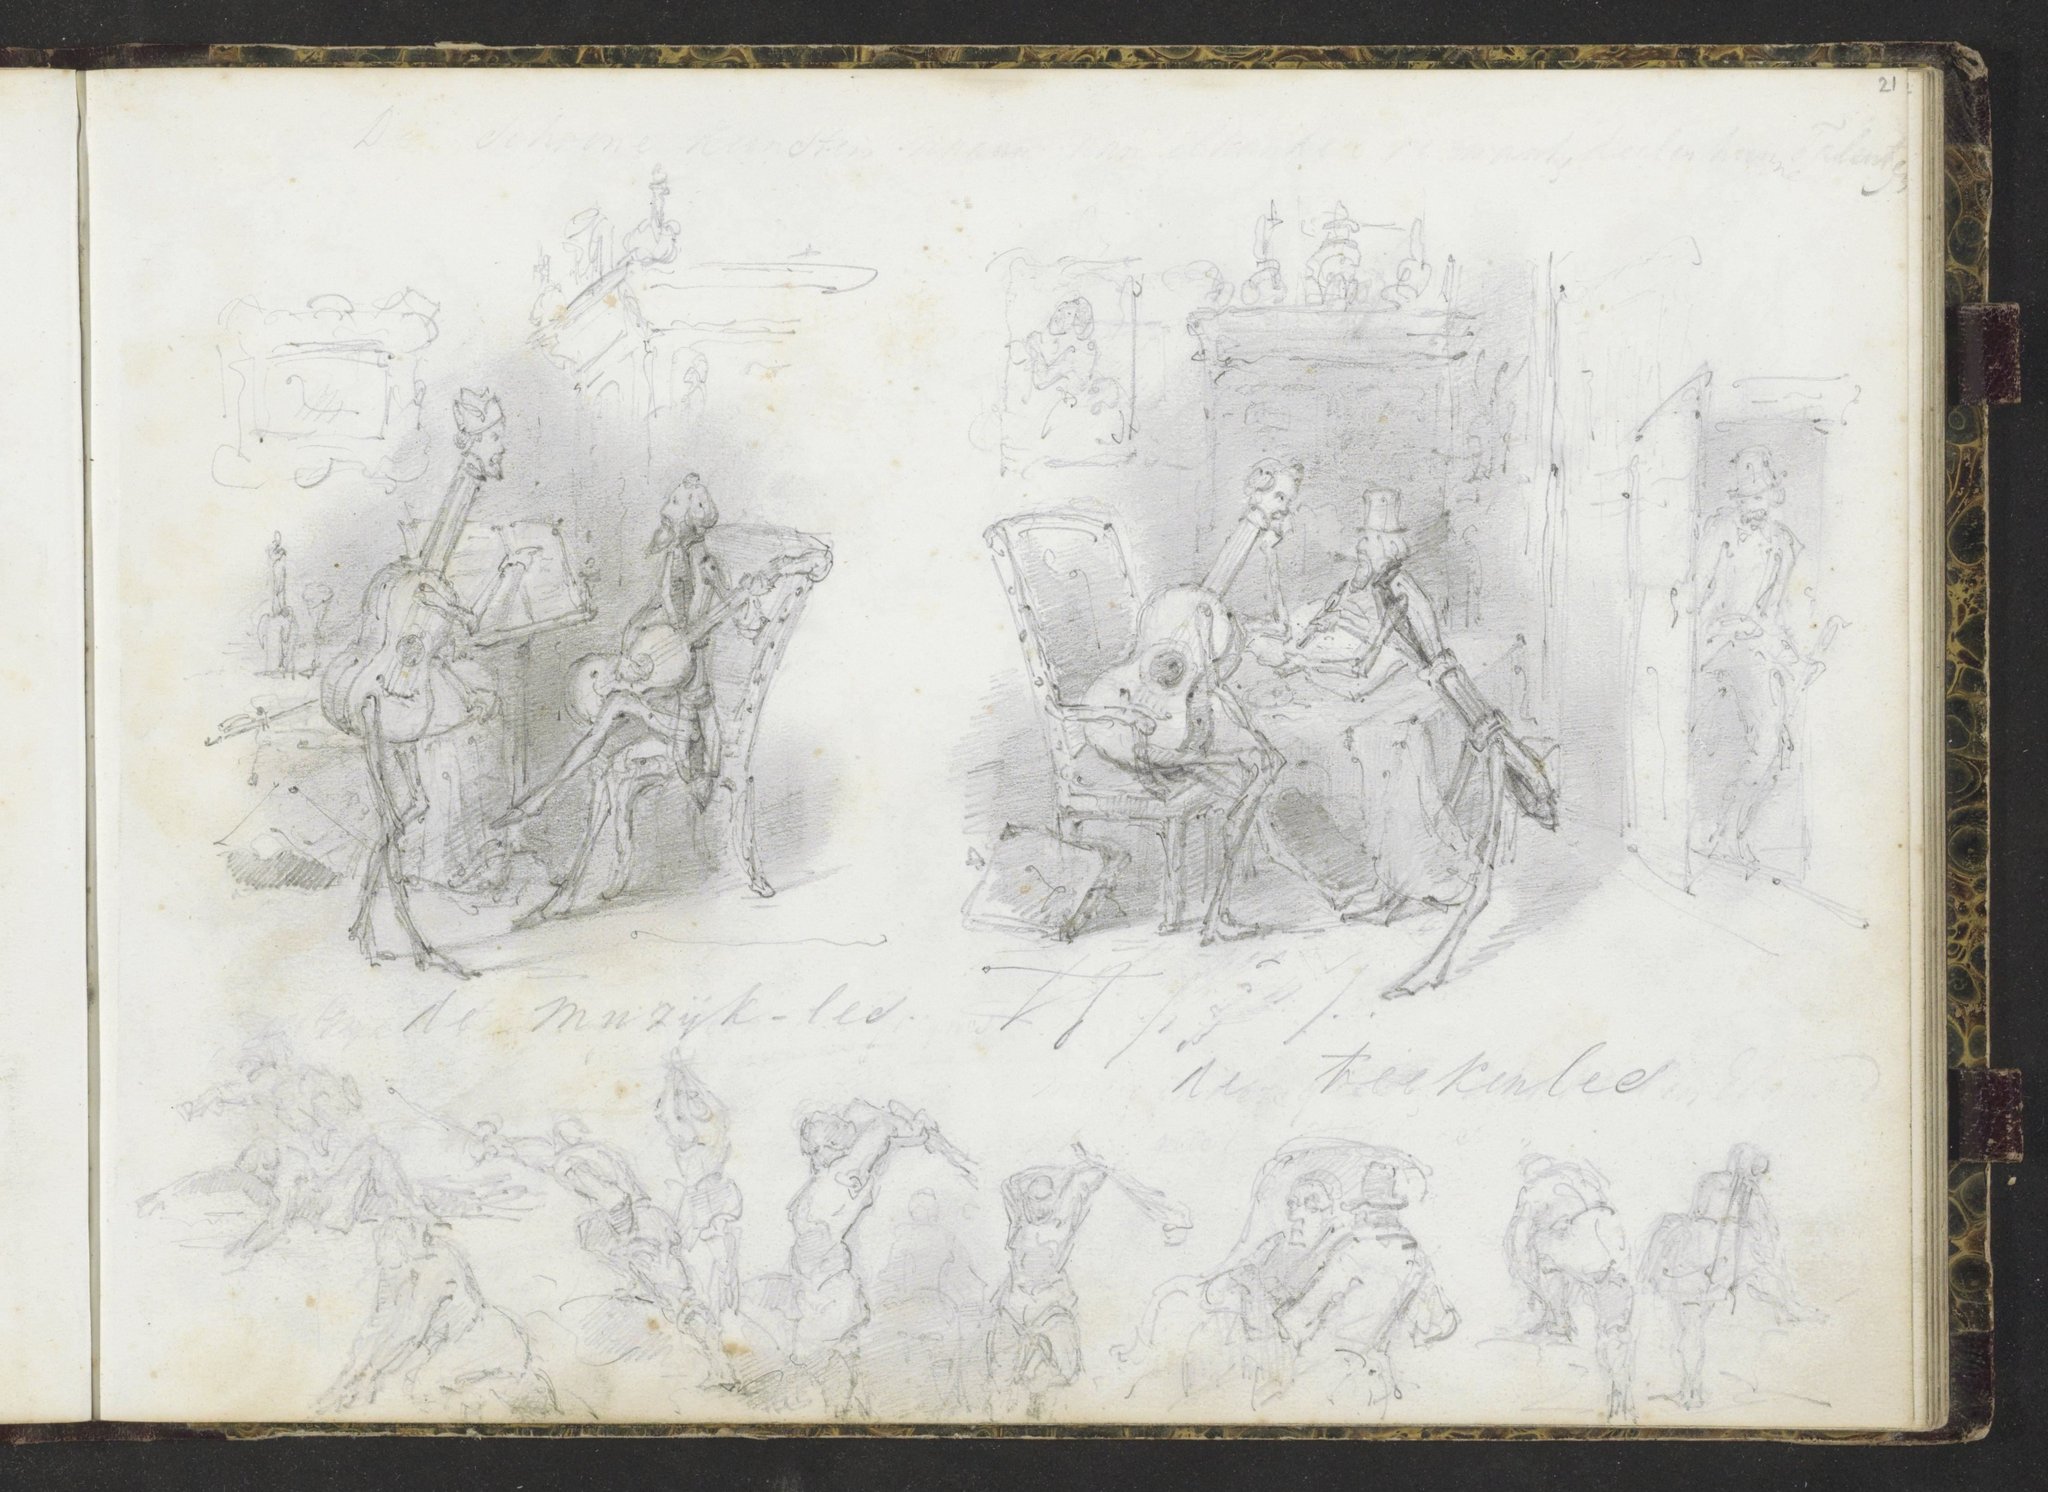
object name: sketchbook leaf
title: Karikaturen van een muziek- en tekenles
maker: lambertus lingeman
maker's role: draughtsman, painter, print maker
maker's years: 1829-1894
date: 1839-1894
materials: paper, pencil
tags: musician training pupils, music-lesson, weapons for striking a blow: club (+ during the battle), drawing-lesson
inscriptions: annotation: ‘de schone kunsten [...] van [...] Talenten/ de muzijk-les/ de teekenles’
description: Twee karikaturale scènes gesitueerd in een interieur waarin een man met een gitaar als bovenlichaam muziekles geeft aan een man. In de tweede scène geeft de laatste man, die een penseelachtig bovenlichaam heeft, de ander tekenles. Tevens studies van een gevecht met knuppels en van mannen in verschillende zit- en stahoudingen. Blad 21 recto uit een schetsboek met 51 bladen.